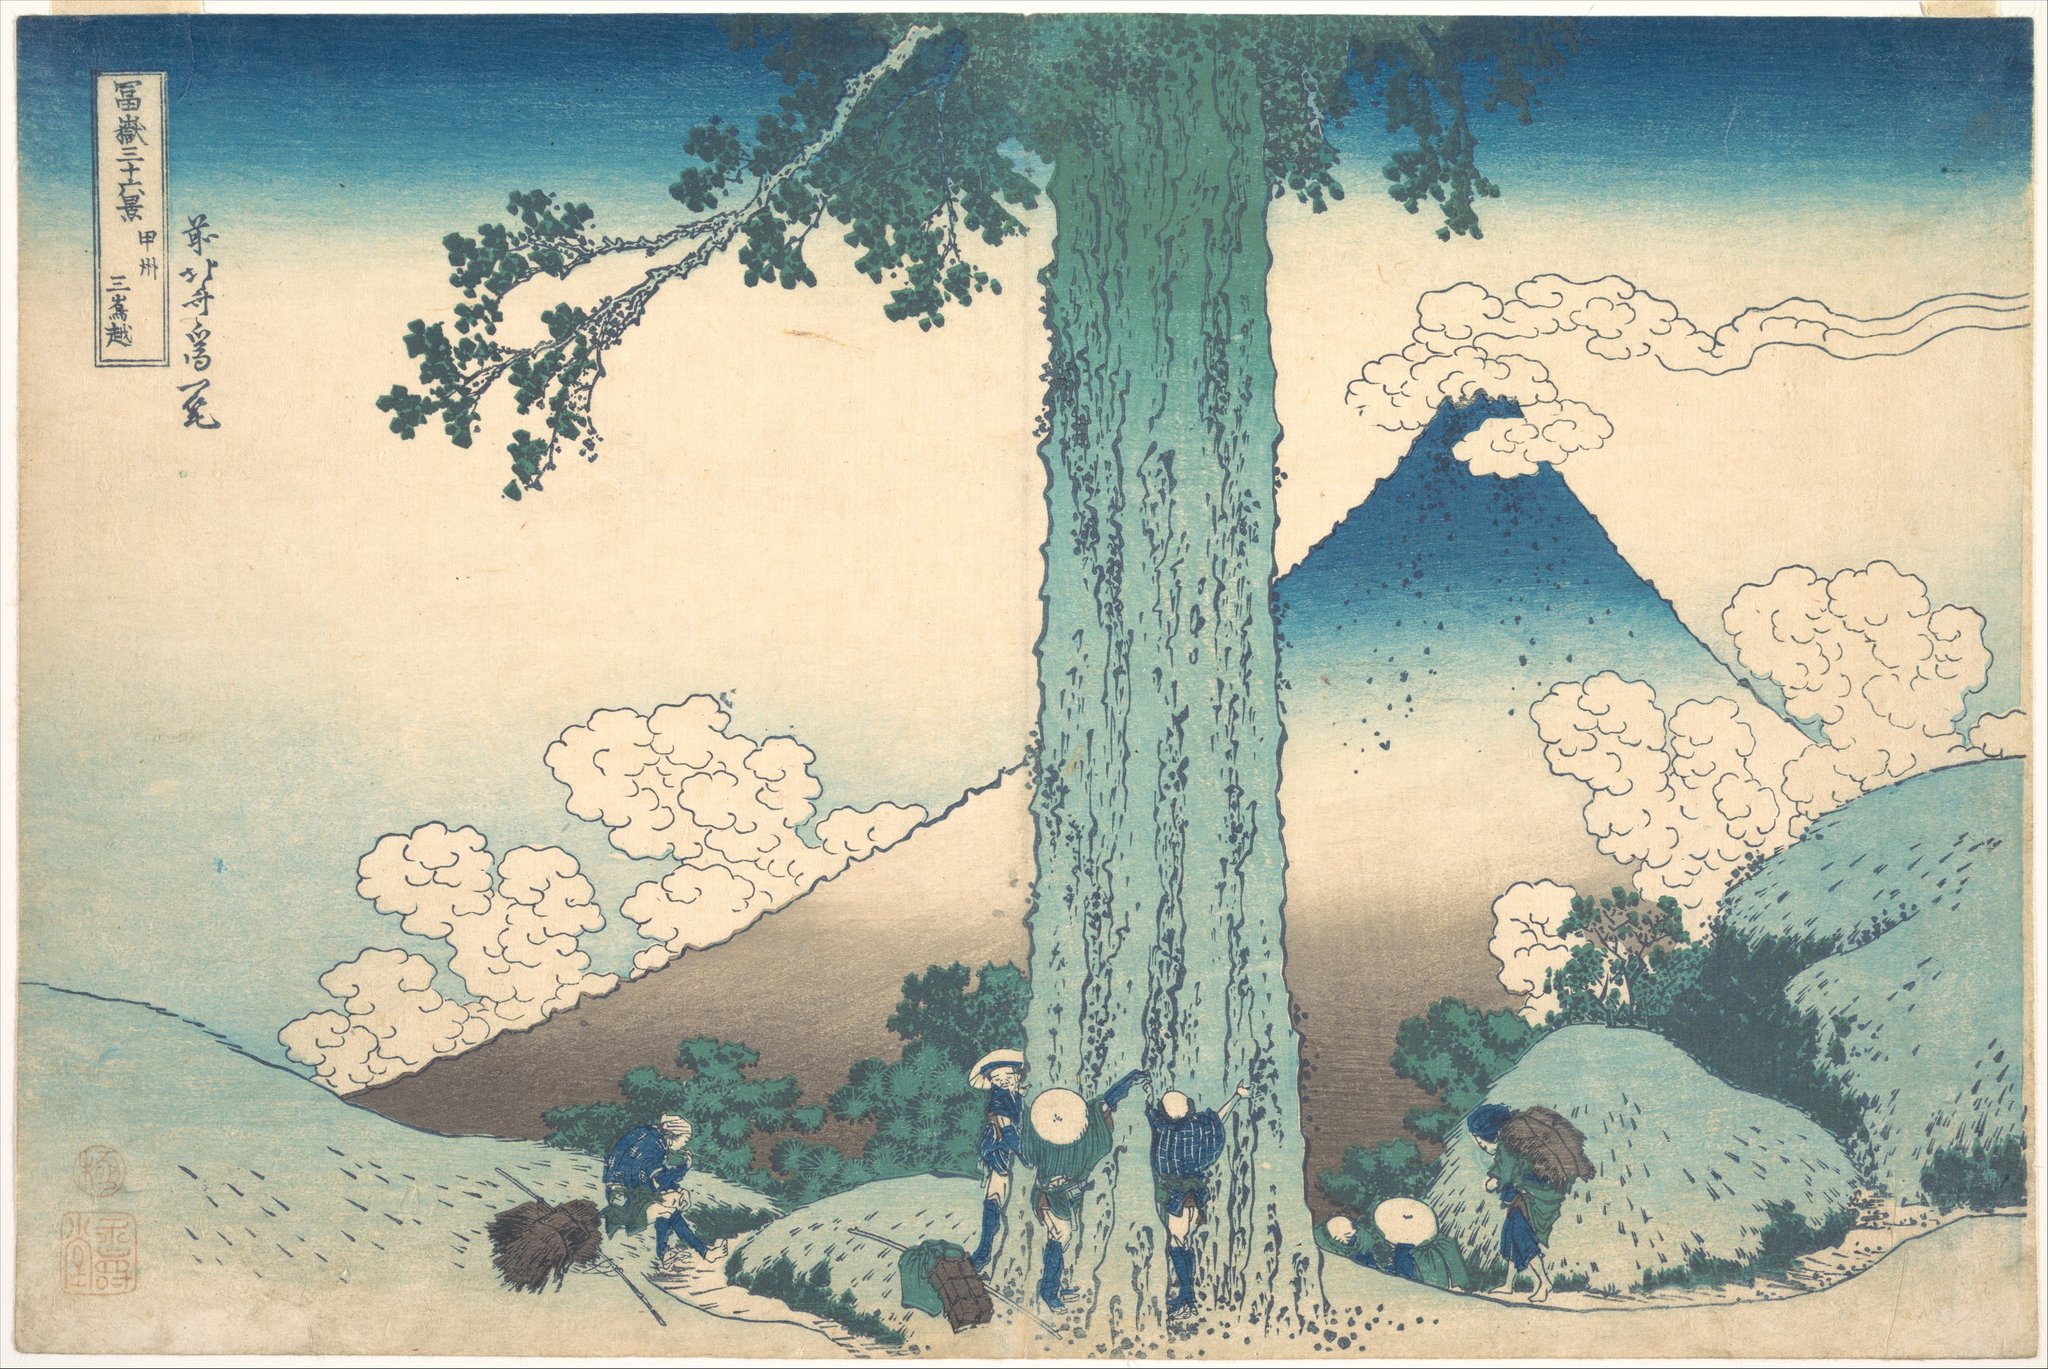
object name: woodblock print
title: Mishima Pass in Kai Province (Kōshū Mishima goe), from the series Thirty-six Views of Mount Fuji (Fugaku sanjūrokkei)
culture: japanese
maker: katsushika hokusai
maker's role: artist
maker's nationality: japanese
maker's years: 1760-1849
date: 1830-1832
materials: ink, paper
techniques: woodblock print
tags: men,mountains,trees